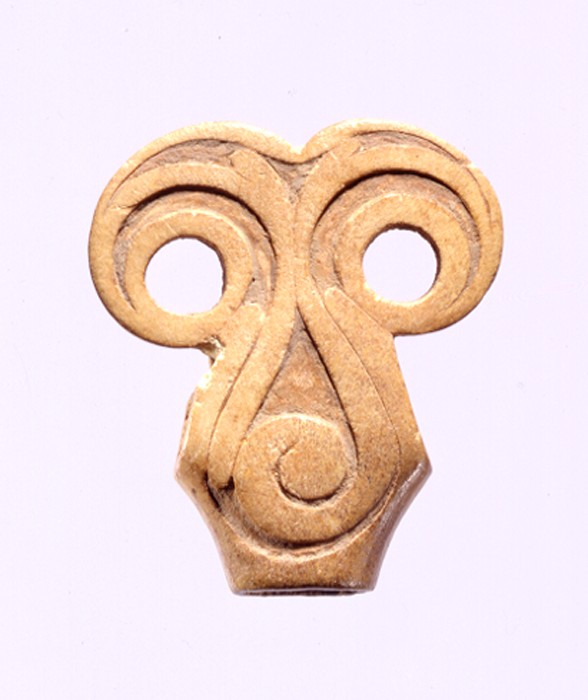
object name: finial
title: Carved Finial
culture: northwest chinese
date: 400-201 BCE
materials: bone